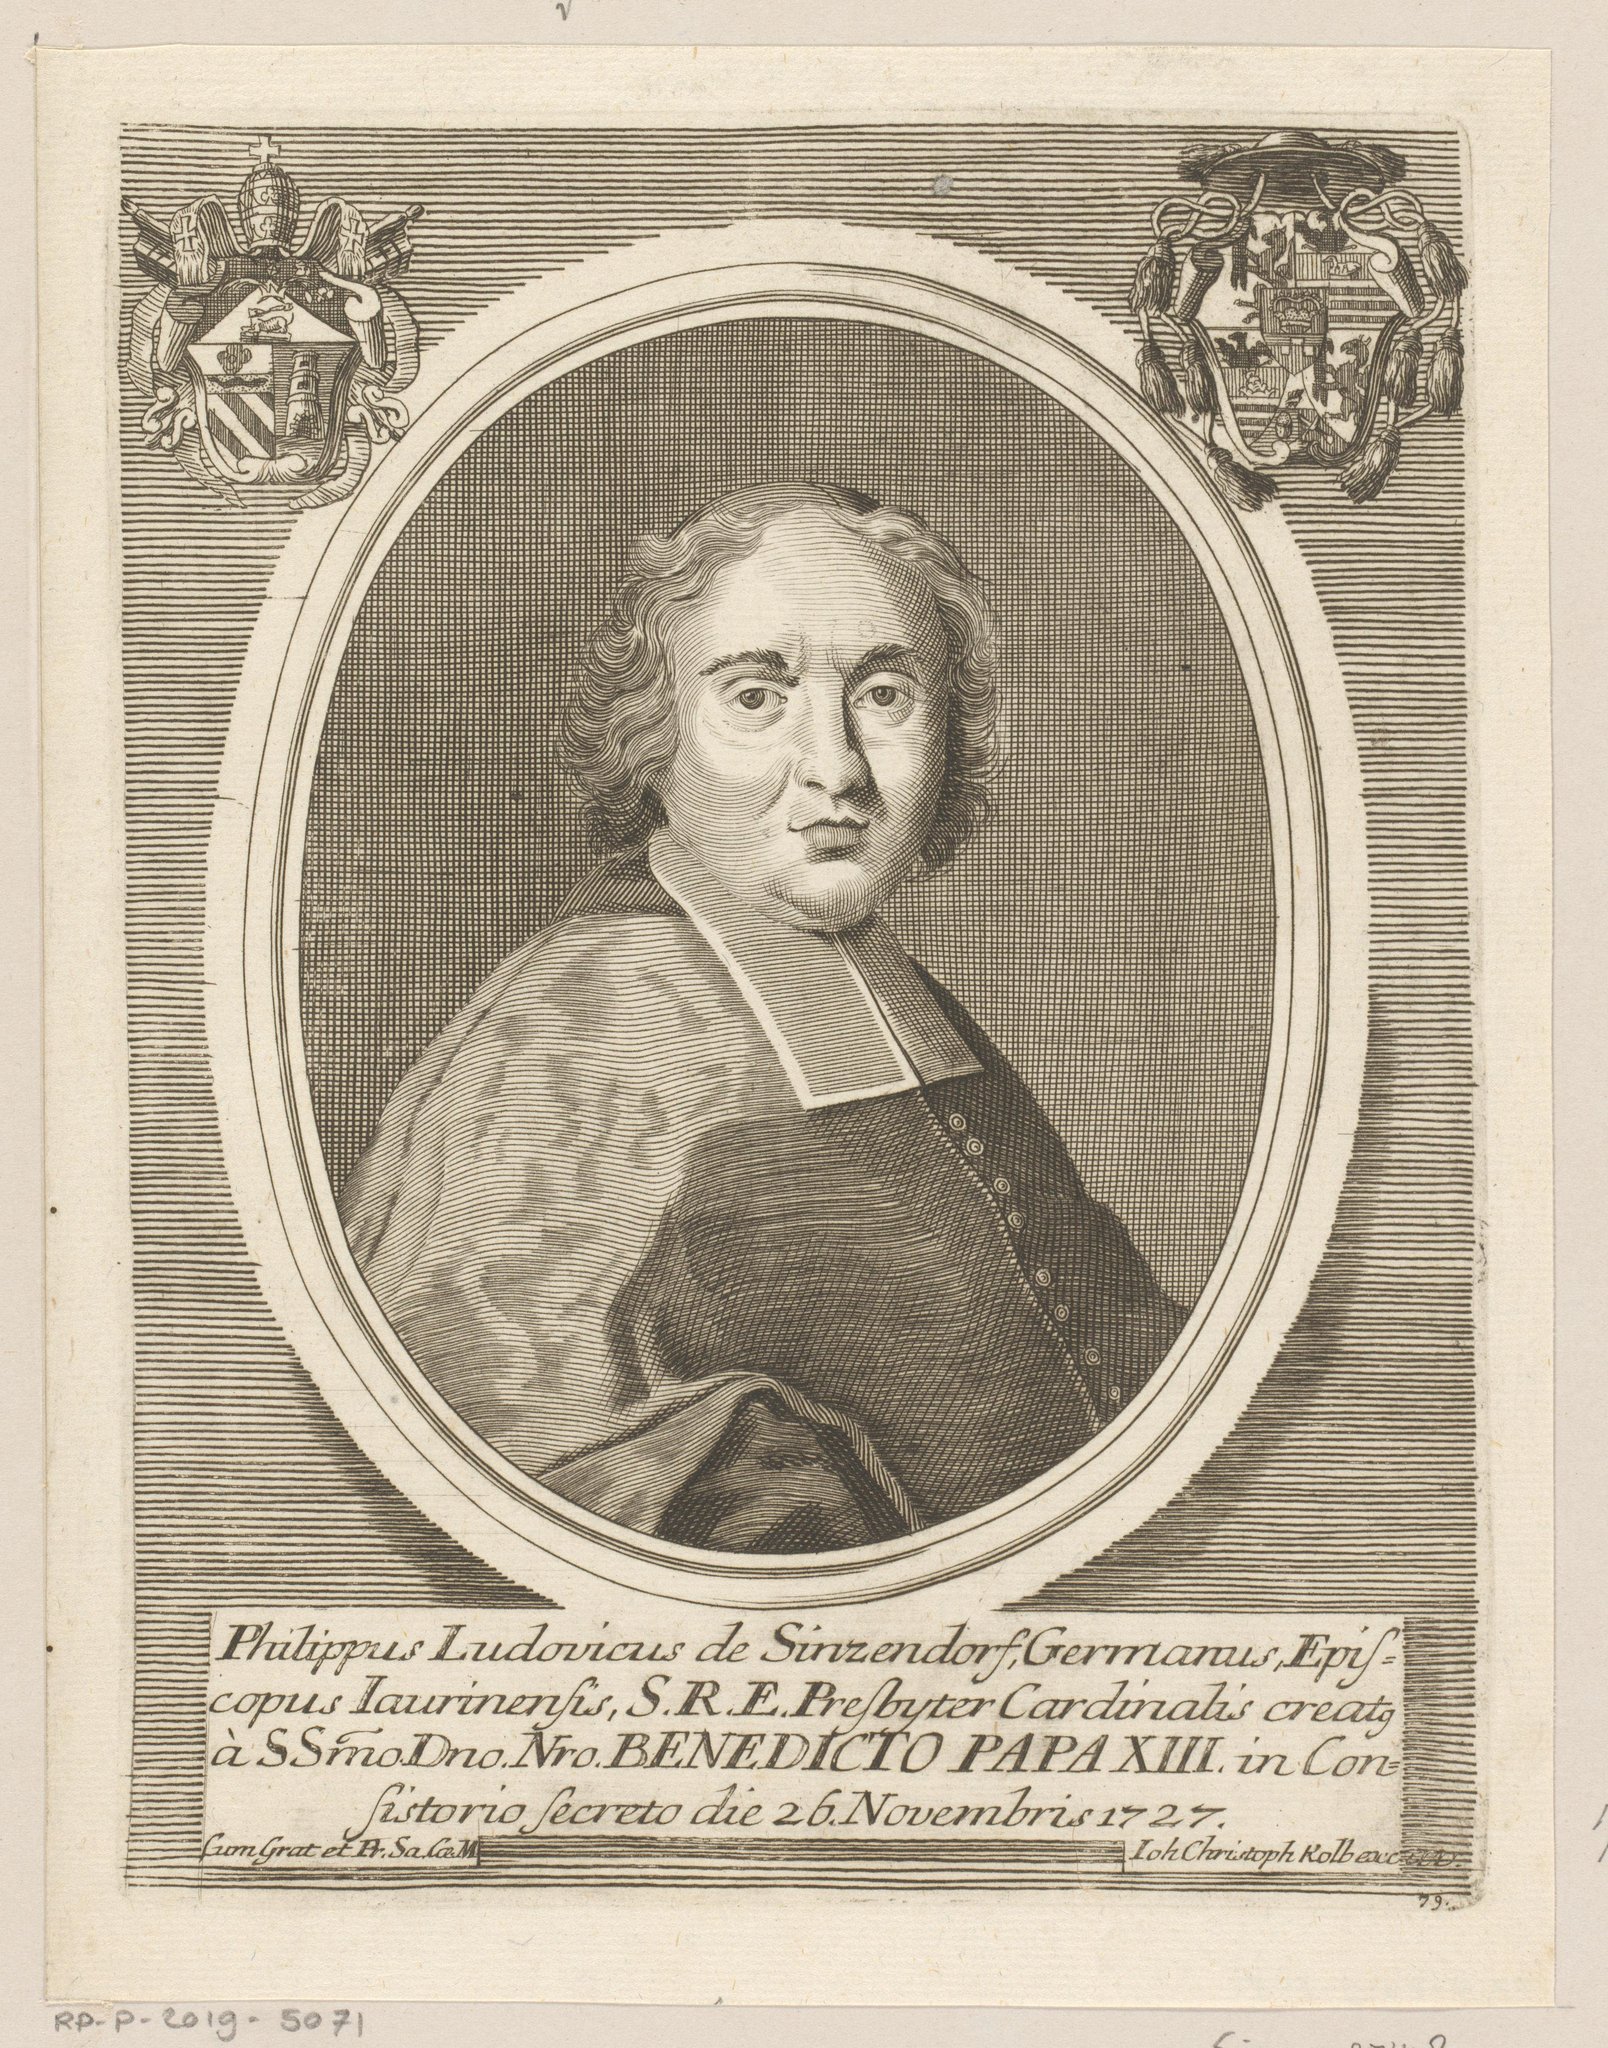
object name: print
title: Portret van kardinaal Philipp Ludwig von Sinzendorf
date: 1727-1743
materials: paper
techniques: engraving, etching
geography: augsburg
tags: cardinal, historical persons, armorial bearing, heraldry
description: Met rechtsboven zijn wapenschild en linksboven het wapen van paus Benedictus XIII. Rechtsonder genummerd: 79.